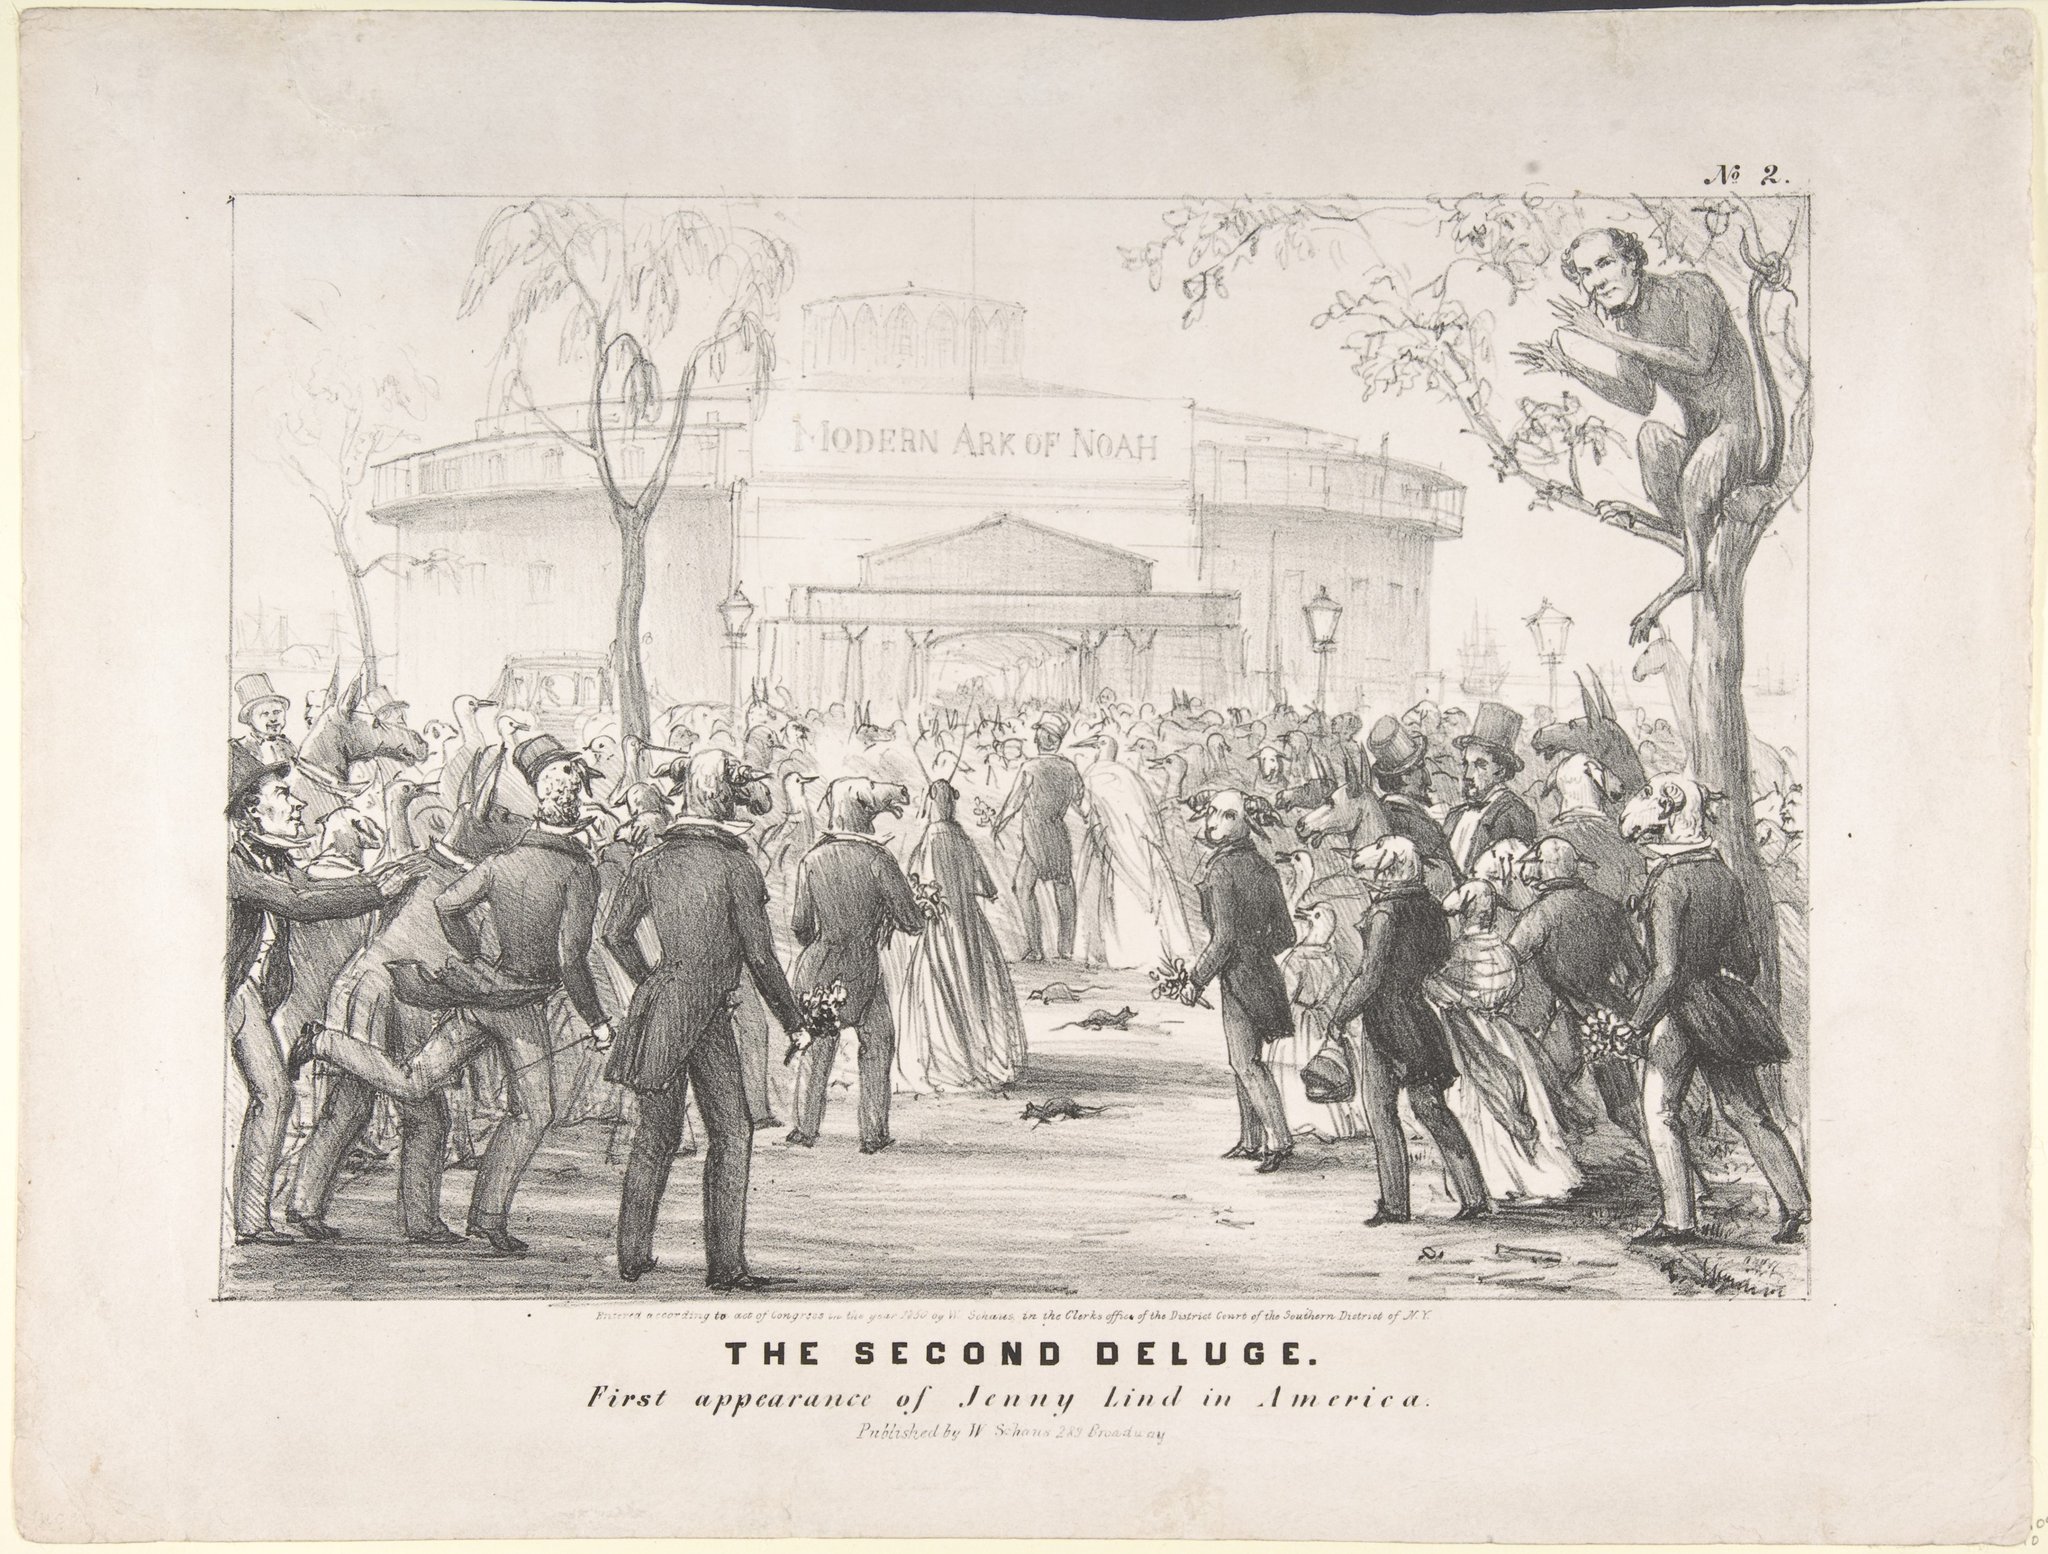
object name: print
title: Castle Gardens, The Second Deluge, First Appearance of Jenny Lind in America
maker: anonymous, american, 19th century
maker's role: artist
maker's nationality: american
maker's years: 1800-1900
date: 1850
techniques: lithograph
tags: men